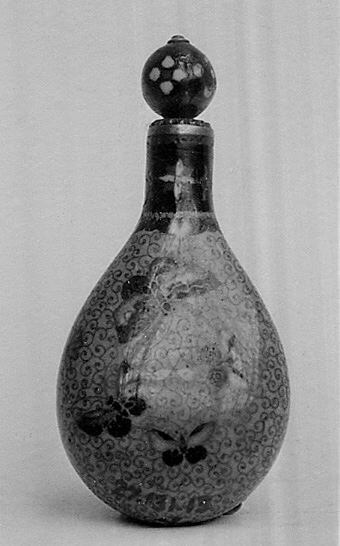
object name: snuff bottle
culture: chinese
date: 1801-1900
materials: enamel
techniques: enamel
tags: butterflies